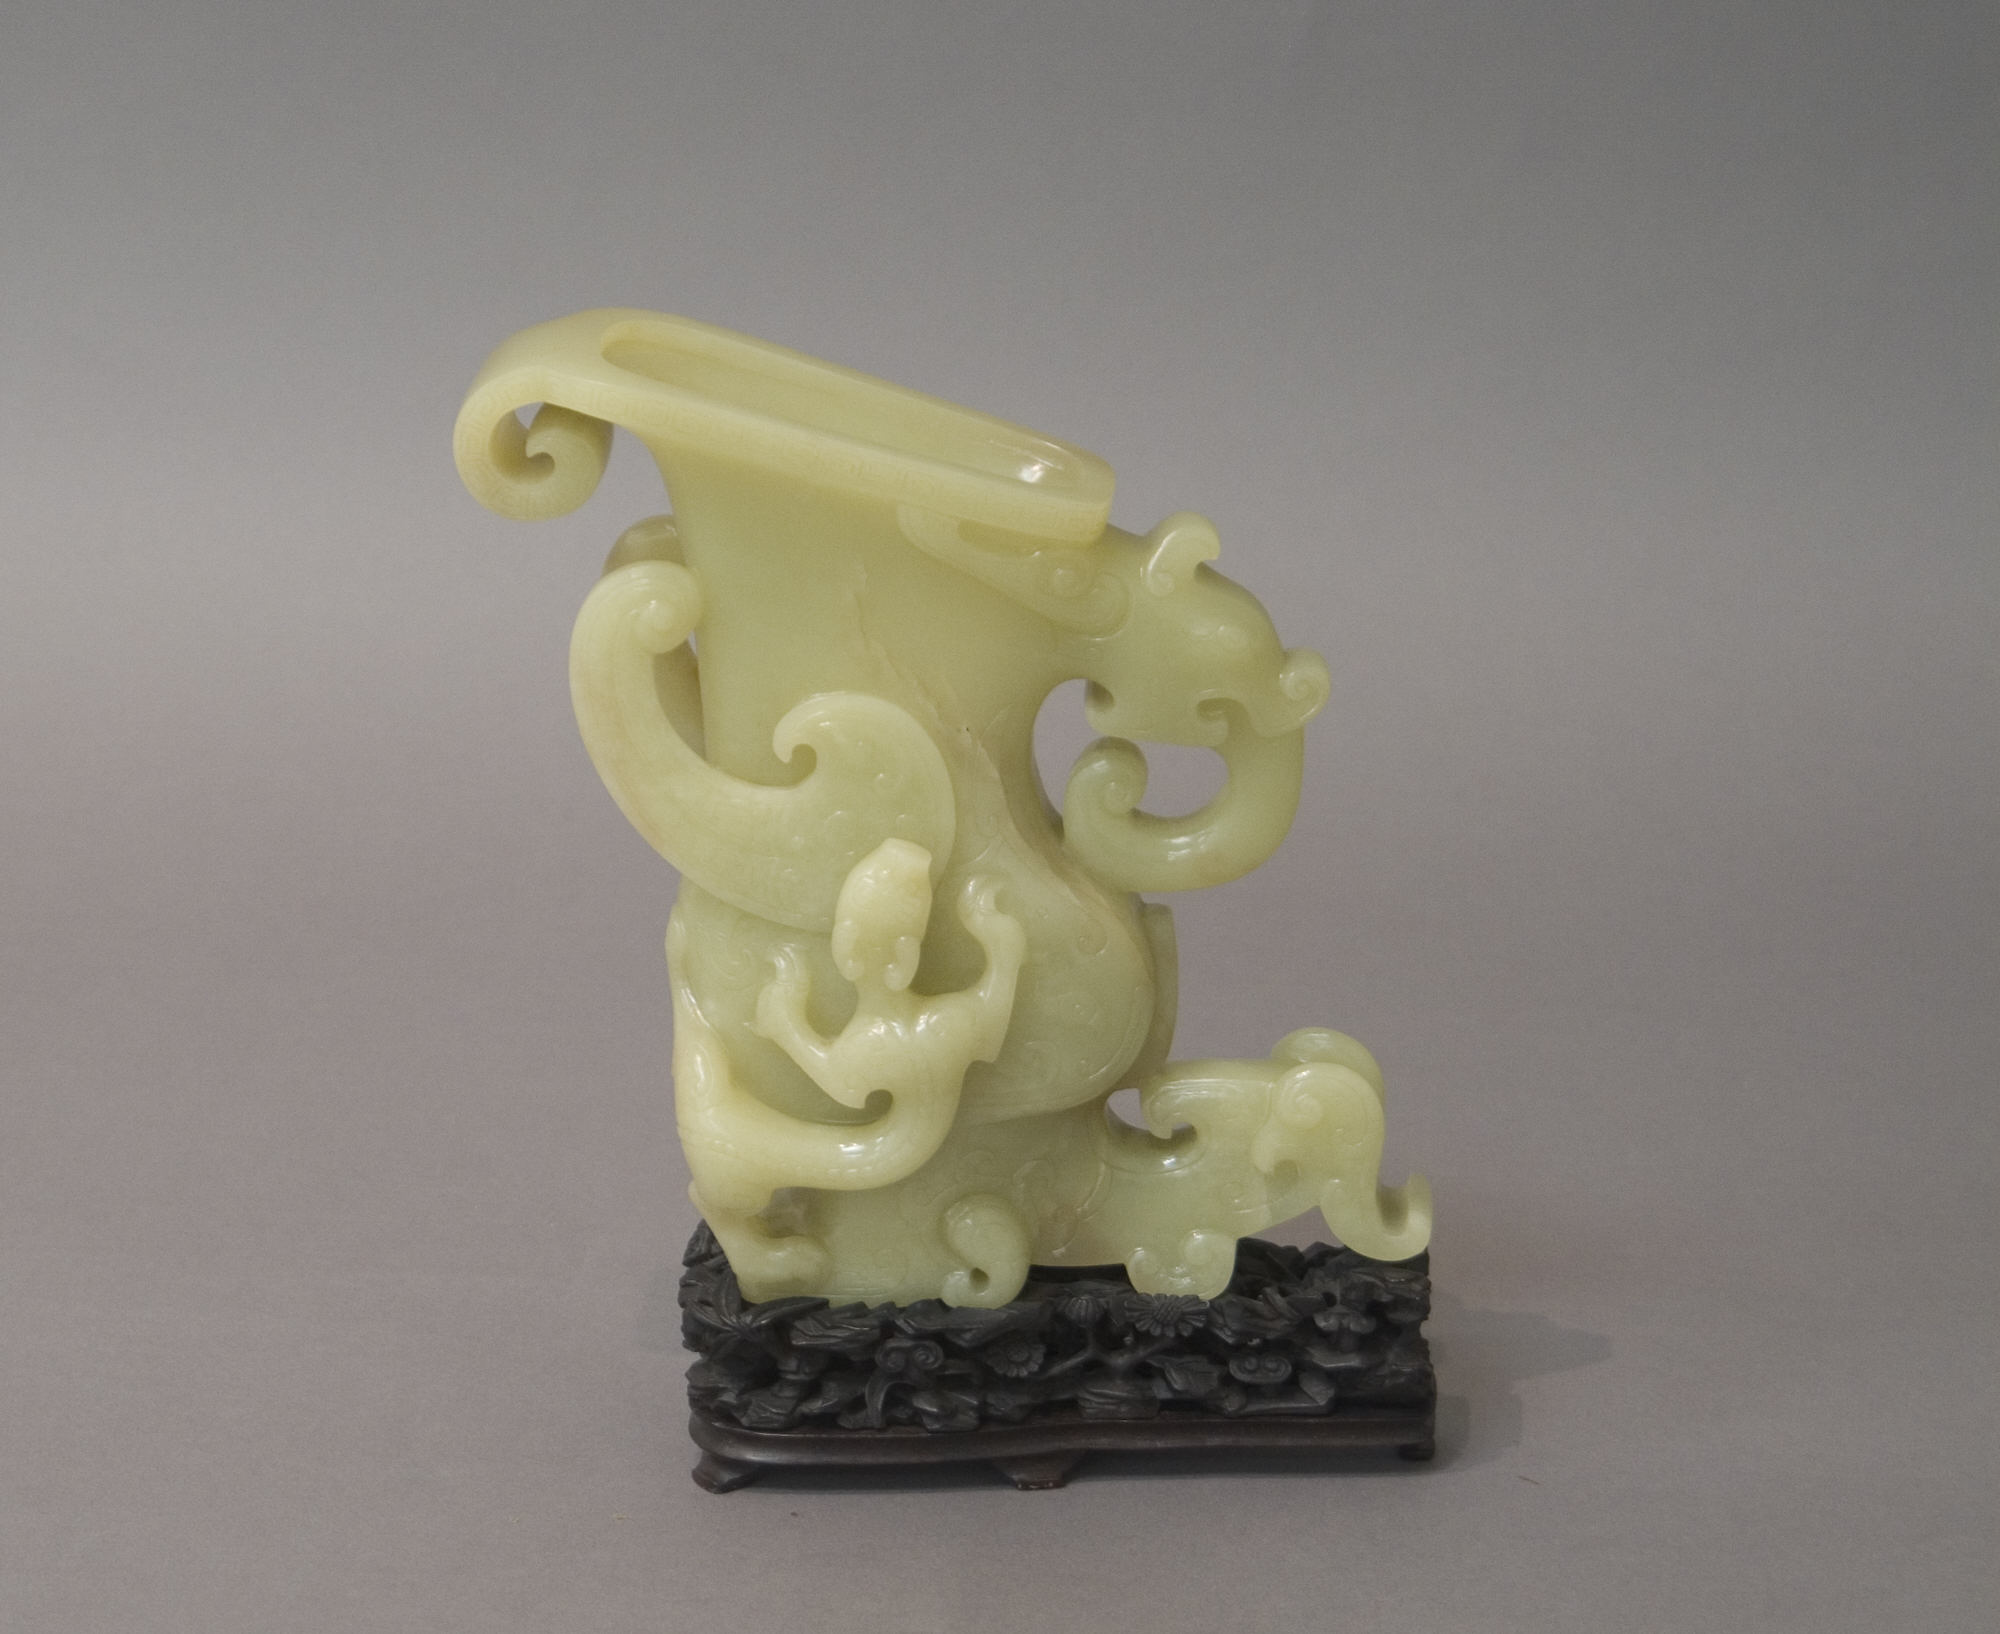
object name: cup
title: Libation Cup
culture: chinese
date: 1662-1722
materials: jade